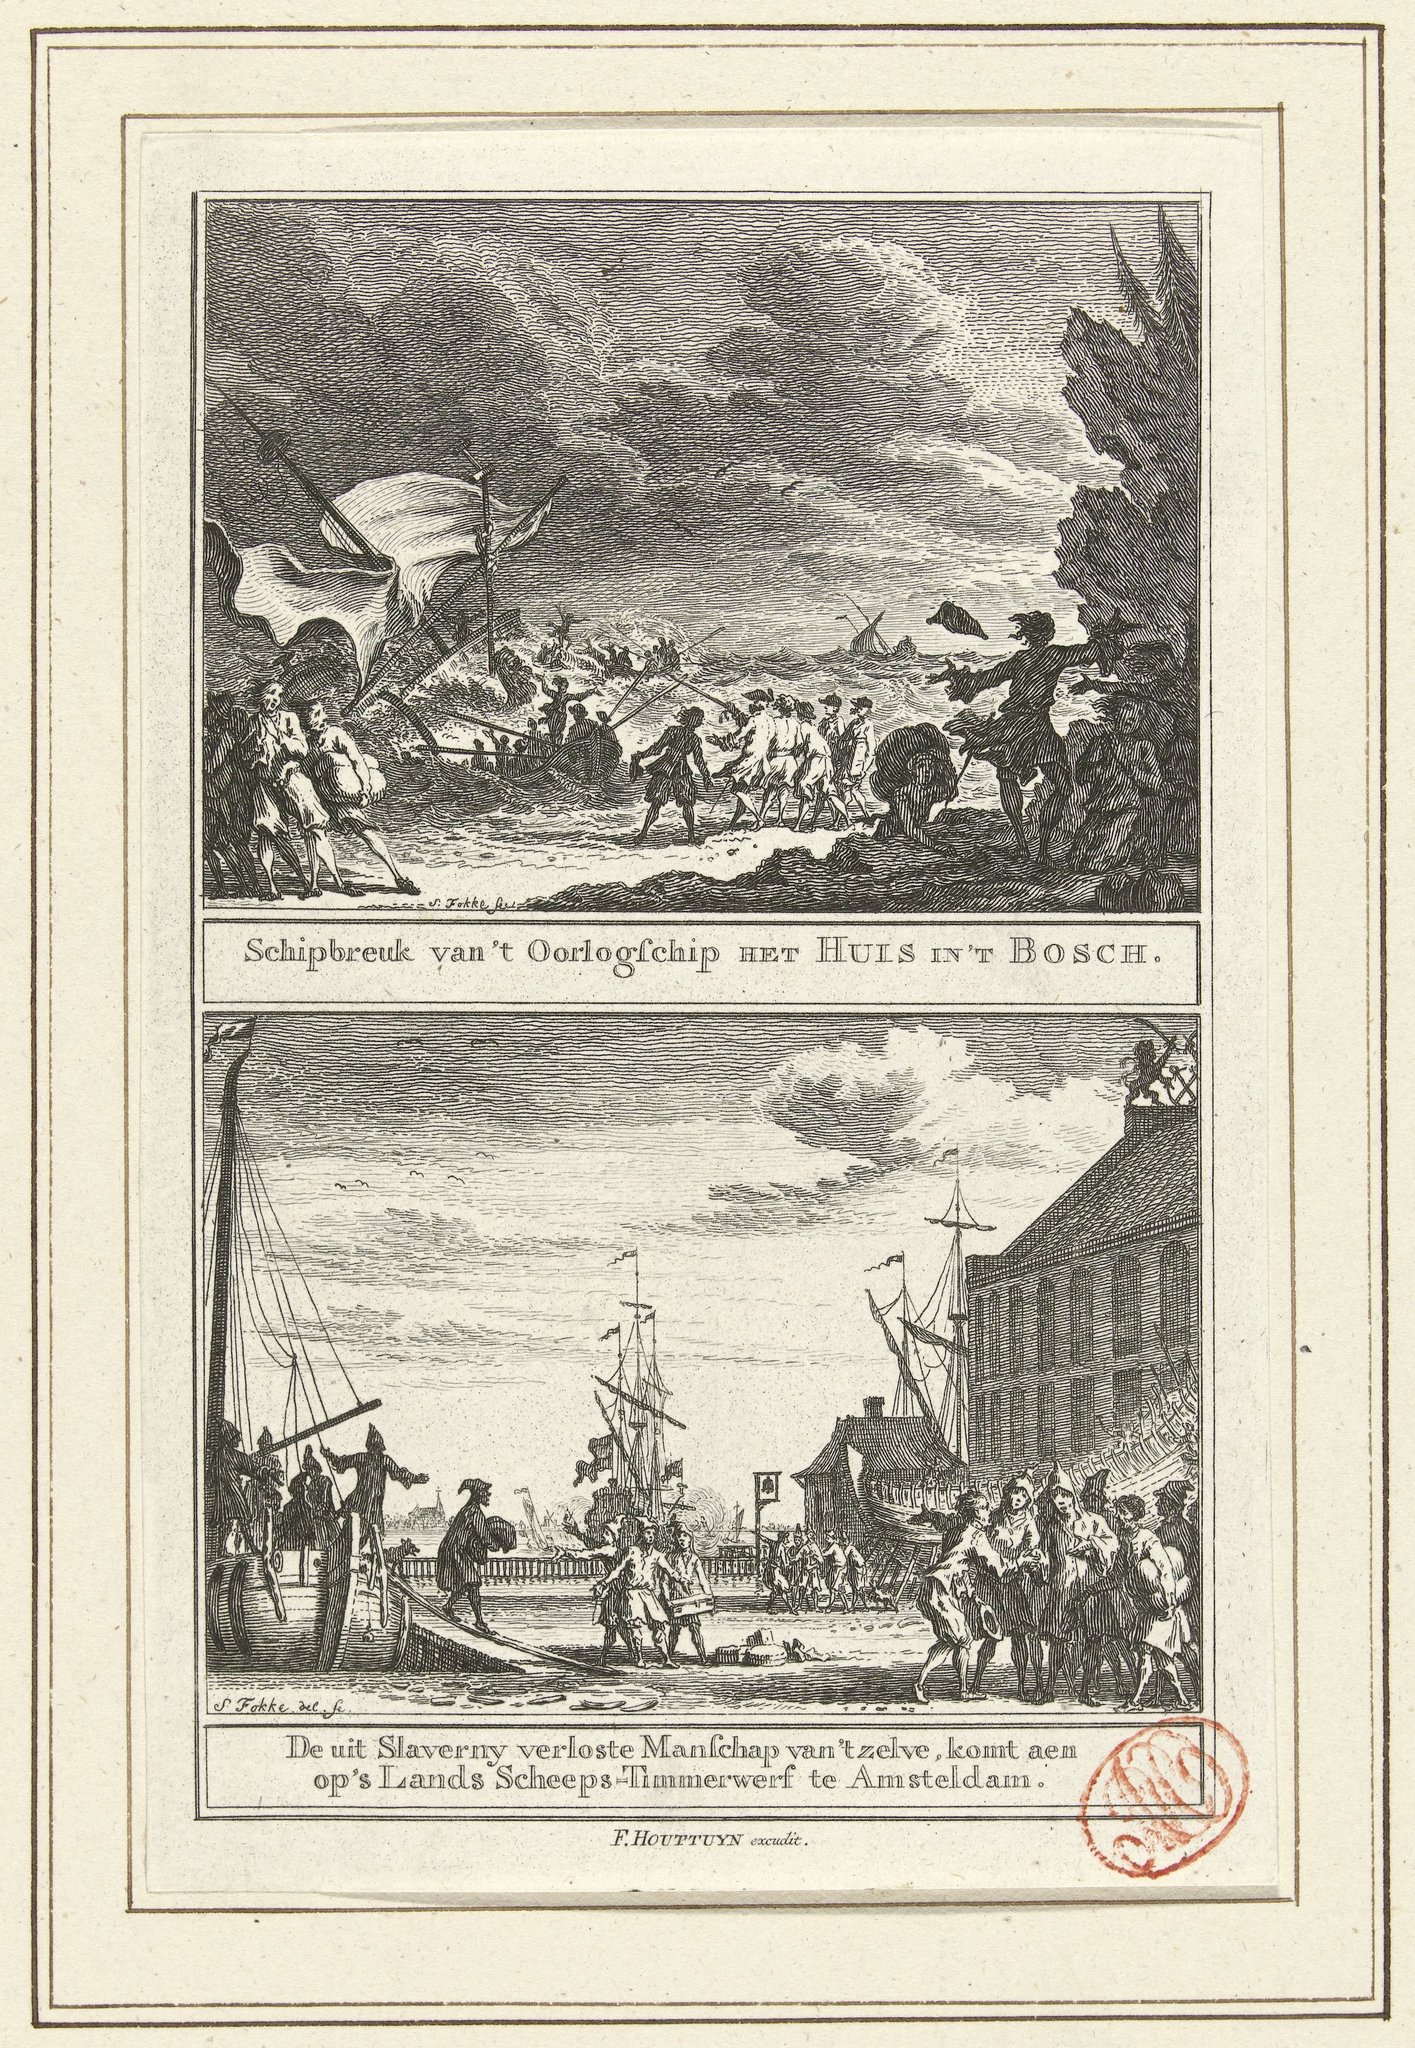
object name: book illustration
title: Schipbreuk van het oorlogsschip Huis in 't Bosch voor de kust van Marokko en de terugkeer van de bemanning uit slavernij, 1751-1753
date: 1753-1754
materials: paper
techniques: engraving, etching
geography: amsterdam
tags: shipwreck, slavery; serfs and enslaved persons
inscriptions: collector's mark: Lugt 195, collector's mark: Lugt 2228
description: Blad met twee voorstellingen. Boven: de schipbreuk van het oorlogsschip Het Huis in 't Bosch onder kapitein H.C. Steenis voor de kust van Marokko op 20 december 1751. Na de schipbreuk was de bemanning door Noord-Afrikaanse kapers tot slaaf gemaakt. Dergelijke slaafgemaakten stonden bekend als 'christenslaven'. Onder: de terugkeer van de uit slavernij losgekochte bemanning van dat schip bij de Admiraliteitswerf te Amsterdam op 23 februari 1753.